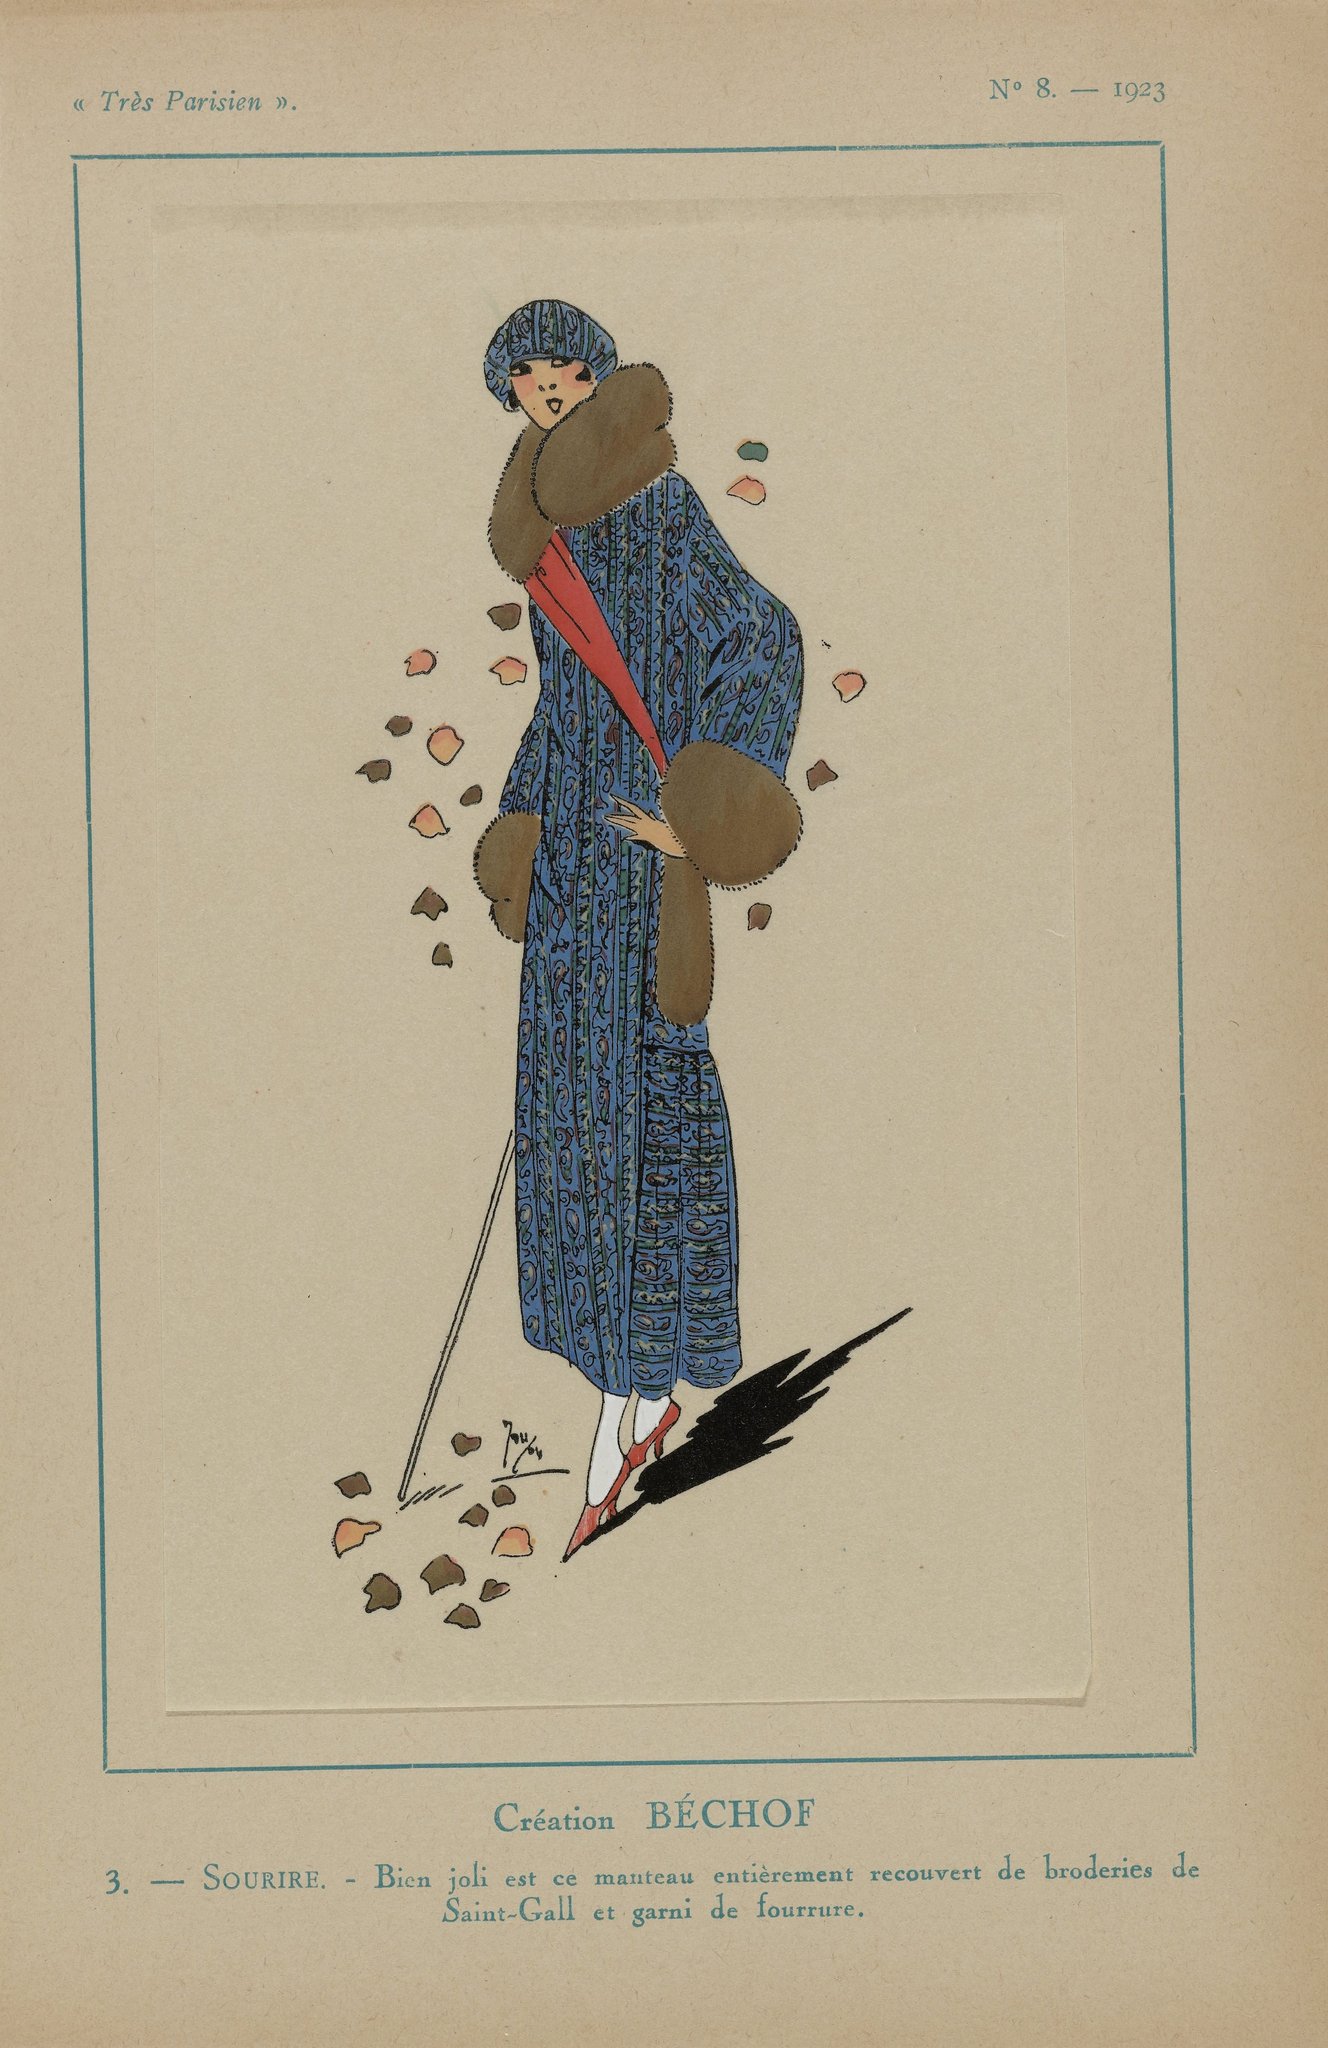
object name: fashion print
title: Très Parisien, 1923, No 8: 3.- SOURIRE. / Bien joli est ce manteau....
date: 1923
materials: paper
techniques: hand coloring, letterpress printing, lithography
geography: paris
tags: walking-stick, staff, cane (+ women's clothes), embroidery (ornamentation) (+ women's clothes), head-gear: beret (+ women's clothes), border, ribbon, braid (+ fur used for clothes), coat (+ women's clothes), fashion plates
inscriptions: title: ‘Très Parisien / No 8. - 1923’, caption: ‘Création Béchof / 3. - SOURIRE. - Bien joli est ce manteau entièrement recouvert de broderies de Saint-Gall et garni de fourrure.’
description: Ontwerp van Béchof. Mantel geheel voorzien van borduurwerk van Saint-Gall en gegarneerd met bont. Accessoires: baret, wandelstok, pumps. Prent uit het modetijdschrift Très Parisien (1920-1936).